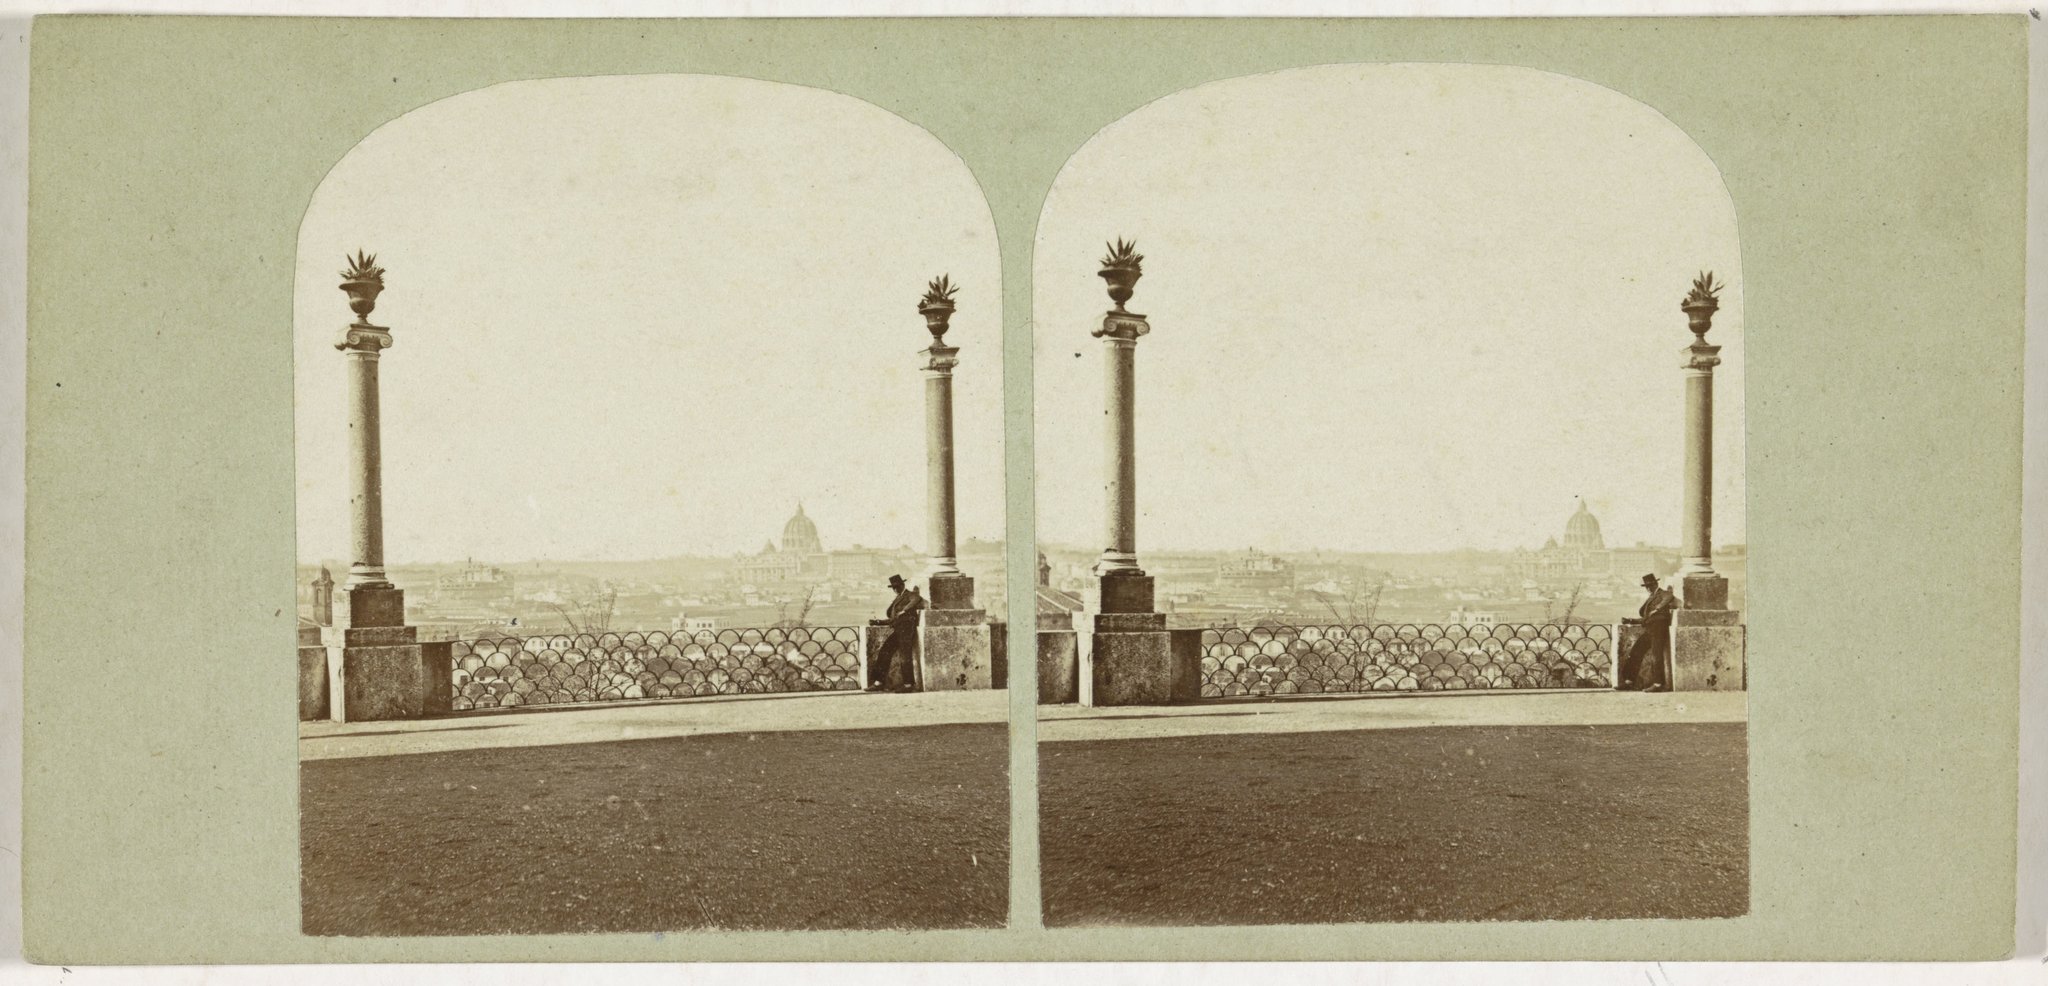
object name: stereograph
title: Gezicht op Rome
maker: Anonymous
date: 1860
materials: cardboard, paper, photographic support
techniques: albumen print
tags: rome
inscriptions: date: ‘c. 1860.’, inscription: ‘15 €’